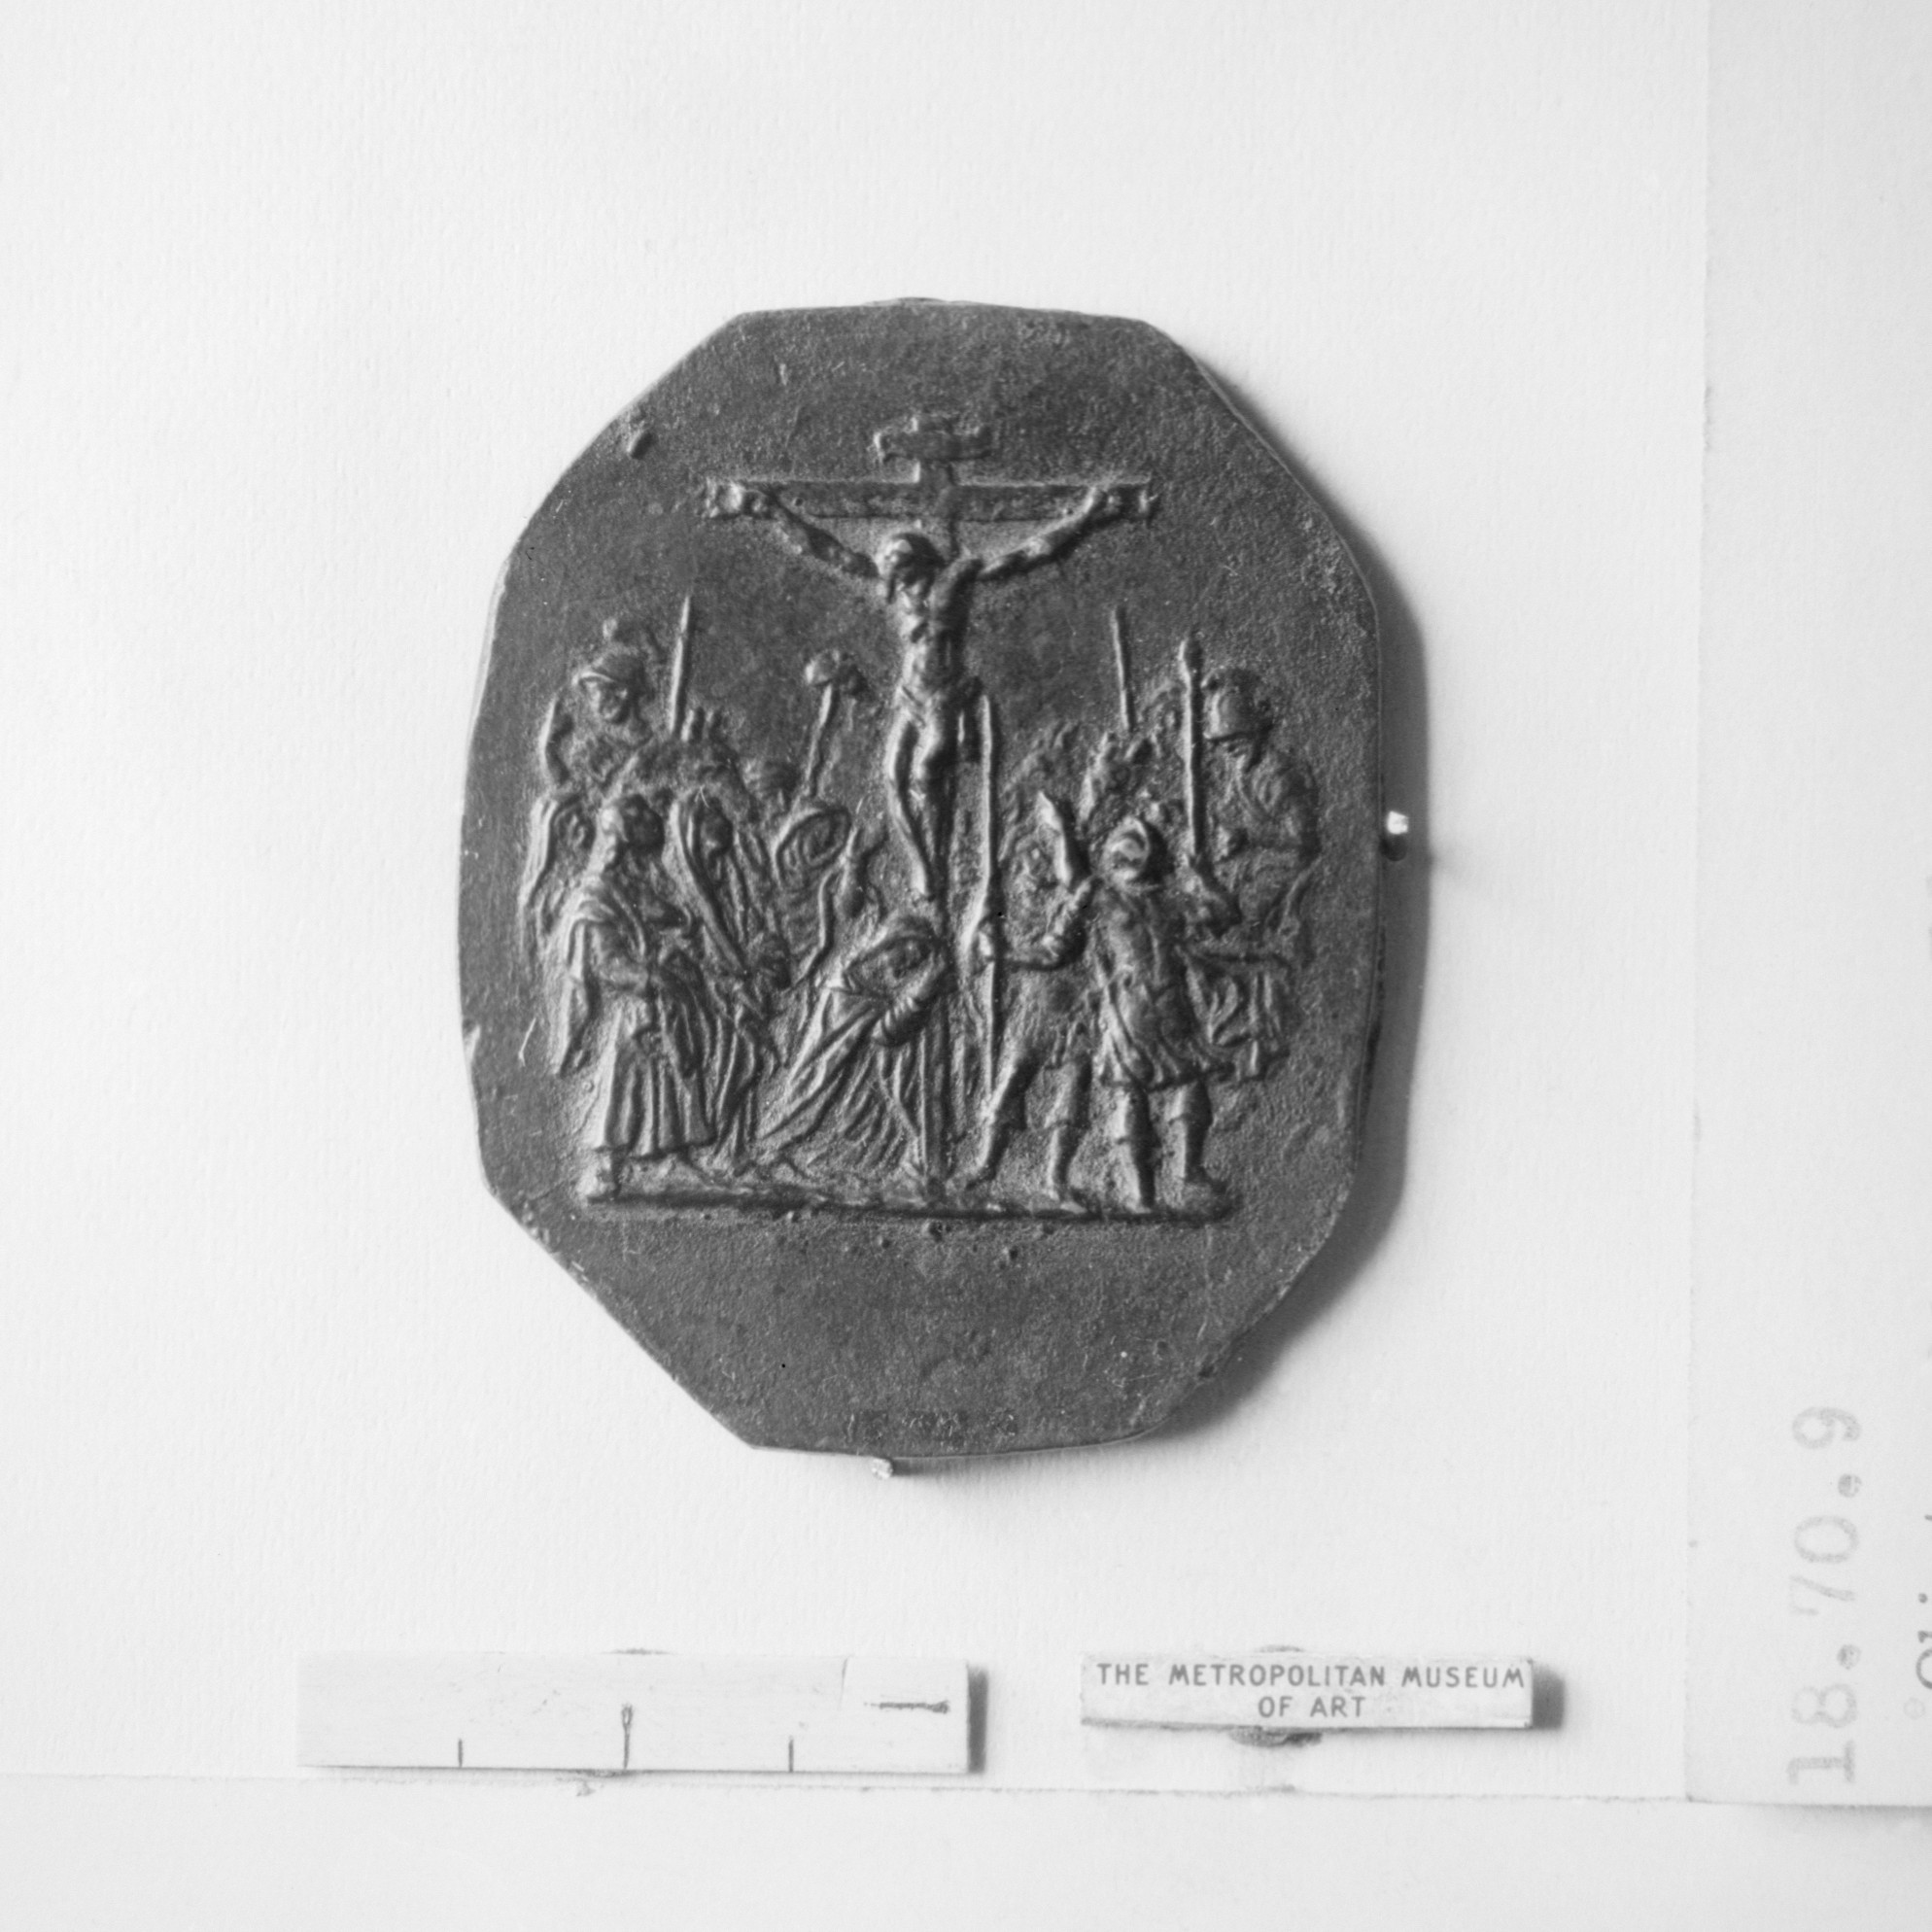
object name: plaquette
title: The Crucifixion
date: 1467-1500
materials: bronze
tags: christ,cross,crucifixion